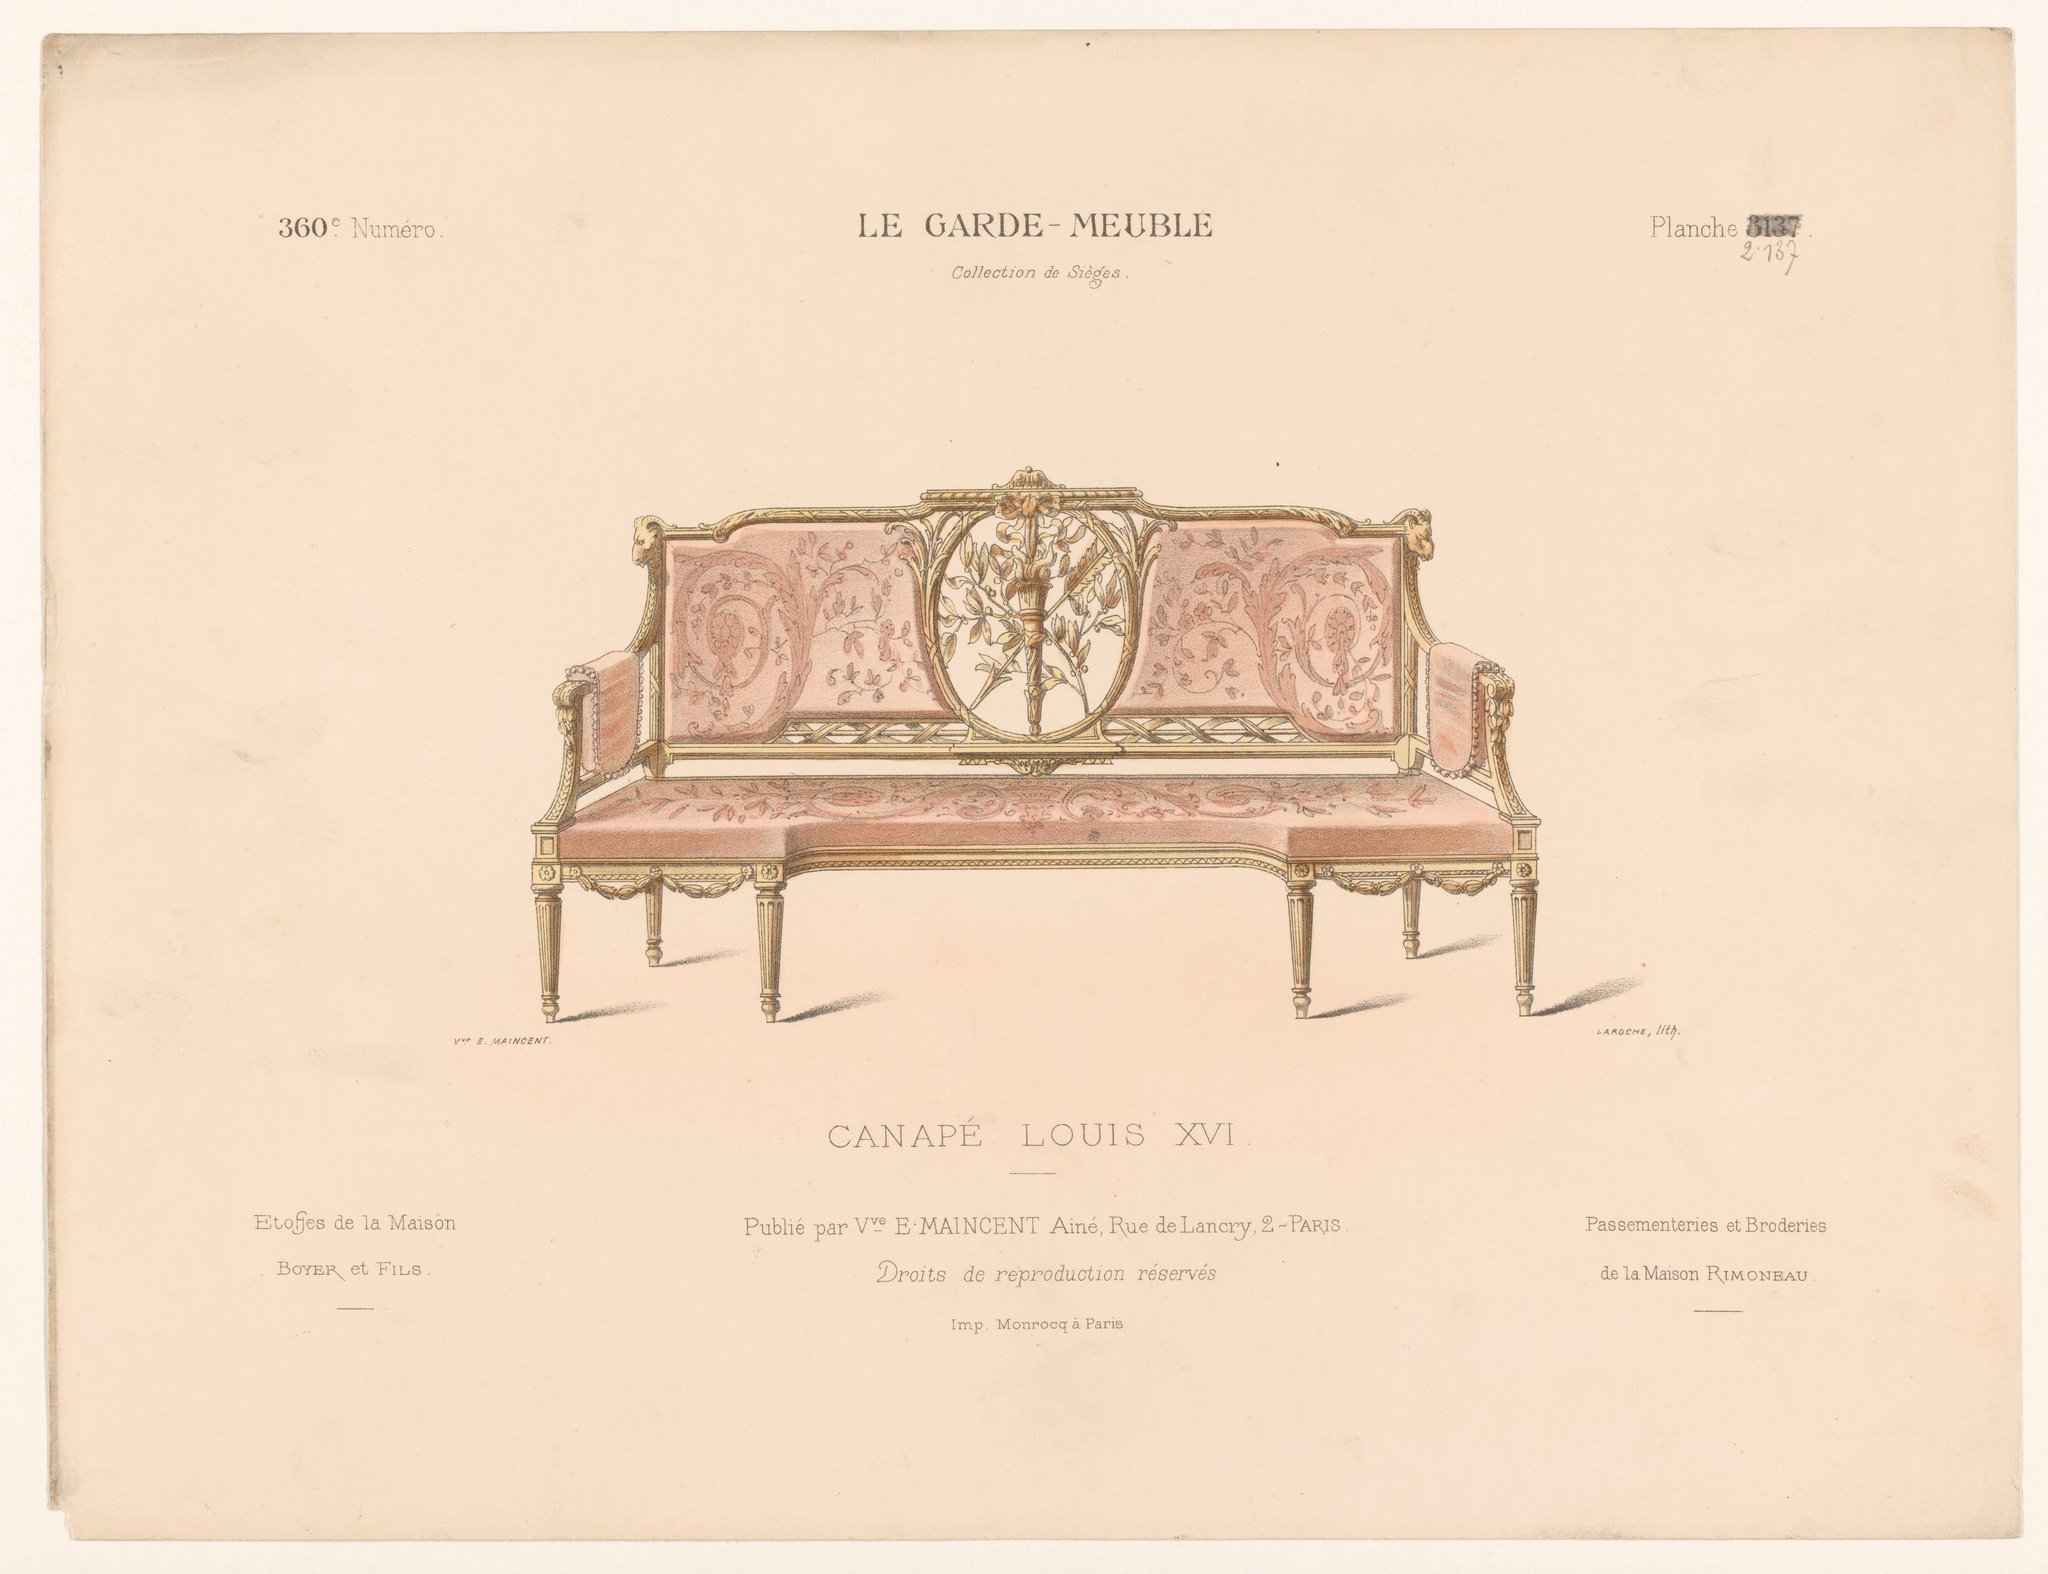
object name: print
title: Canapé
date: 1895-1935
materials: paper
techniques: hand coloring, lithograph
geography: paris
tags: seating furniture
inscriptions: number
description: Ieder Livraison in de serie Le Garde-Meuble bevat negen platen: drie 'sièges' (zitmeubels), drie 'meubles' (diverse meubels zoals tafels en kasten) en drie 'tentures' (gordijnen en draperieën).